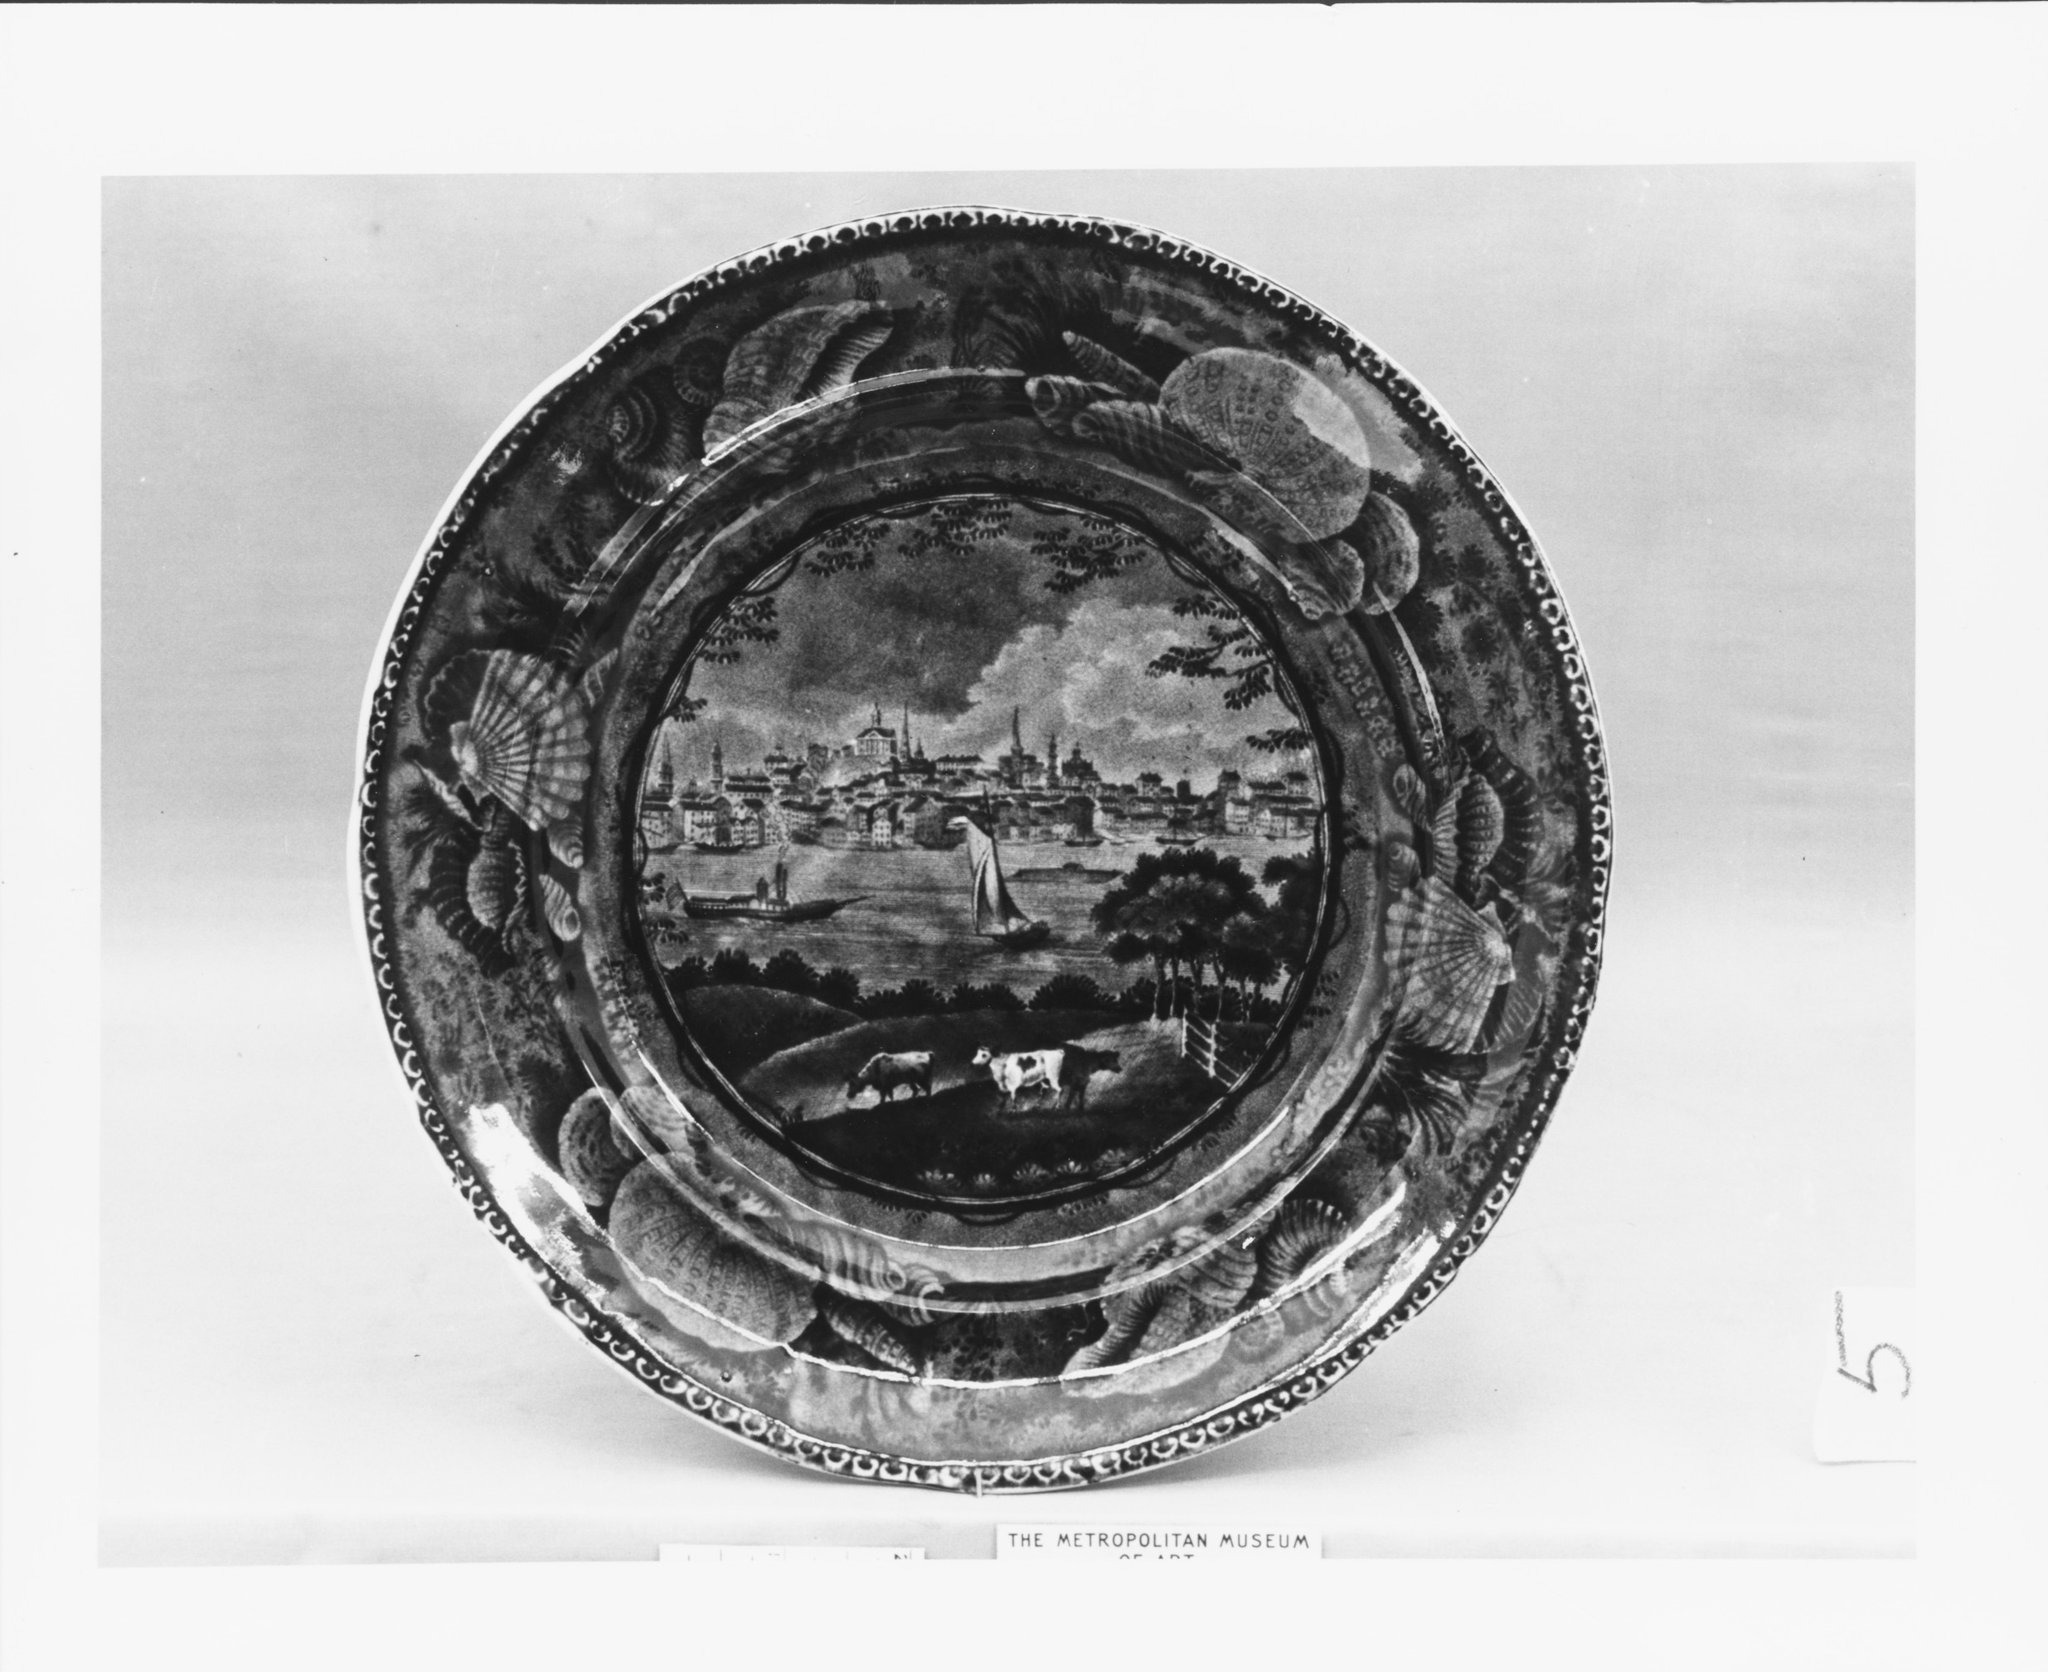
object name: plate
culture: british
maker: enoch wood & sons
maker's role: maker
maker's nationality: british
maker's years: 1818-1846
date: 1818-1846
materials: earthenware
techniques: transfer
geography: england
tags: animals,landscapes,boats